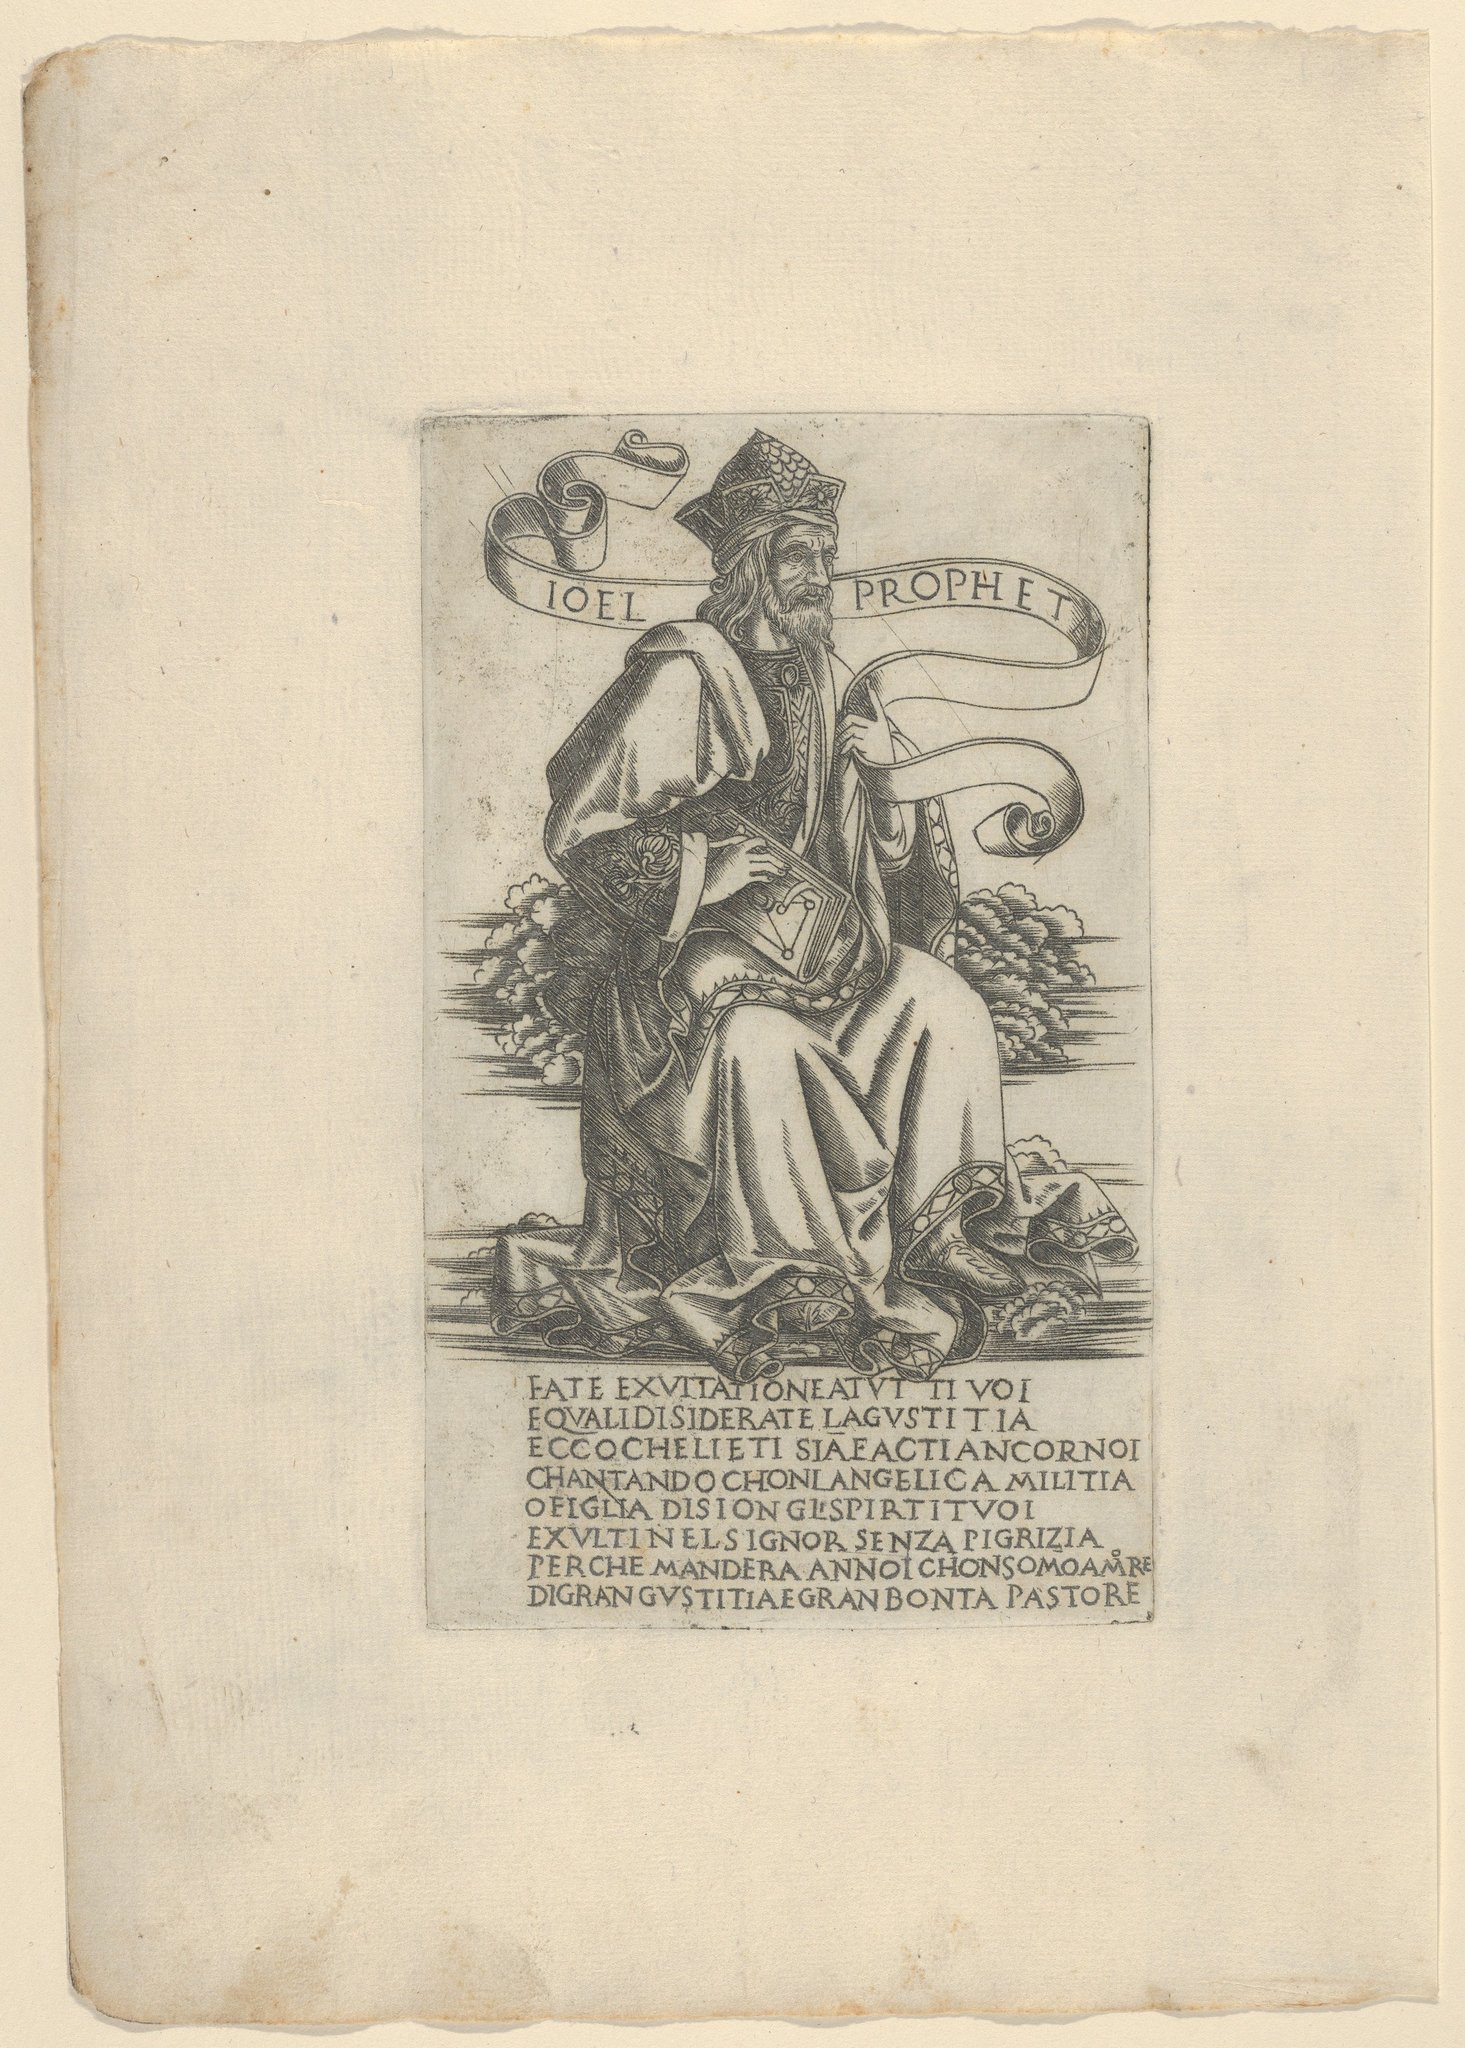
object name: print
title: The Prophet Joel, from Prophets and Sibyls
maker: francesco rosselli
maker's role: artist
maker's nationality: italian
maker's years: 1448-1527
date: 1480-1490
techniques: engraving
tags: men